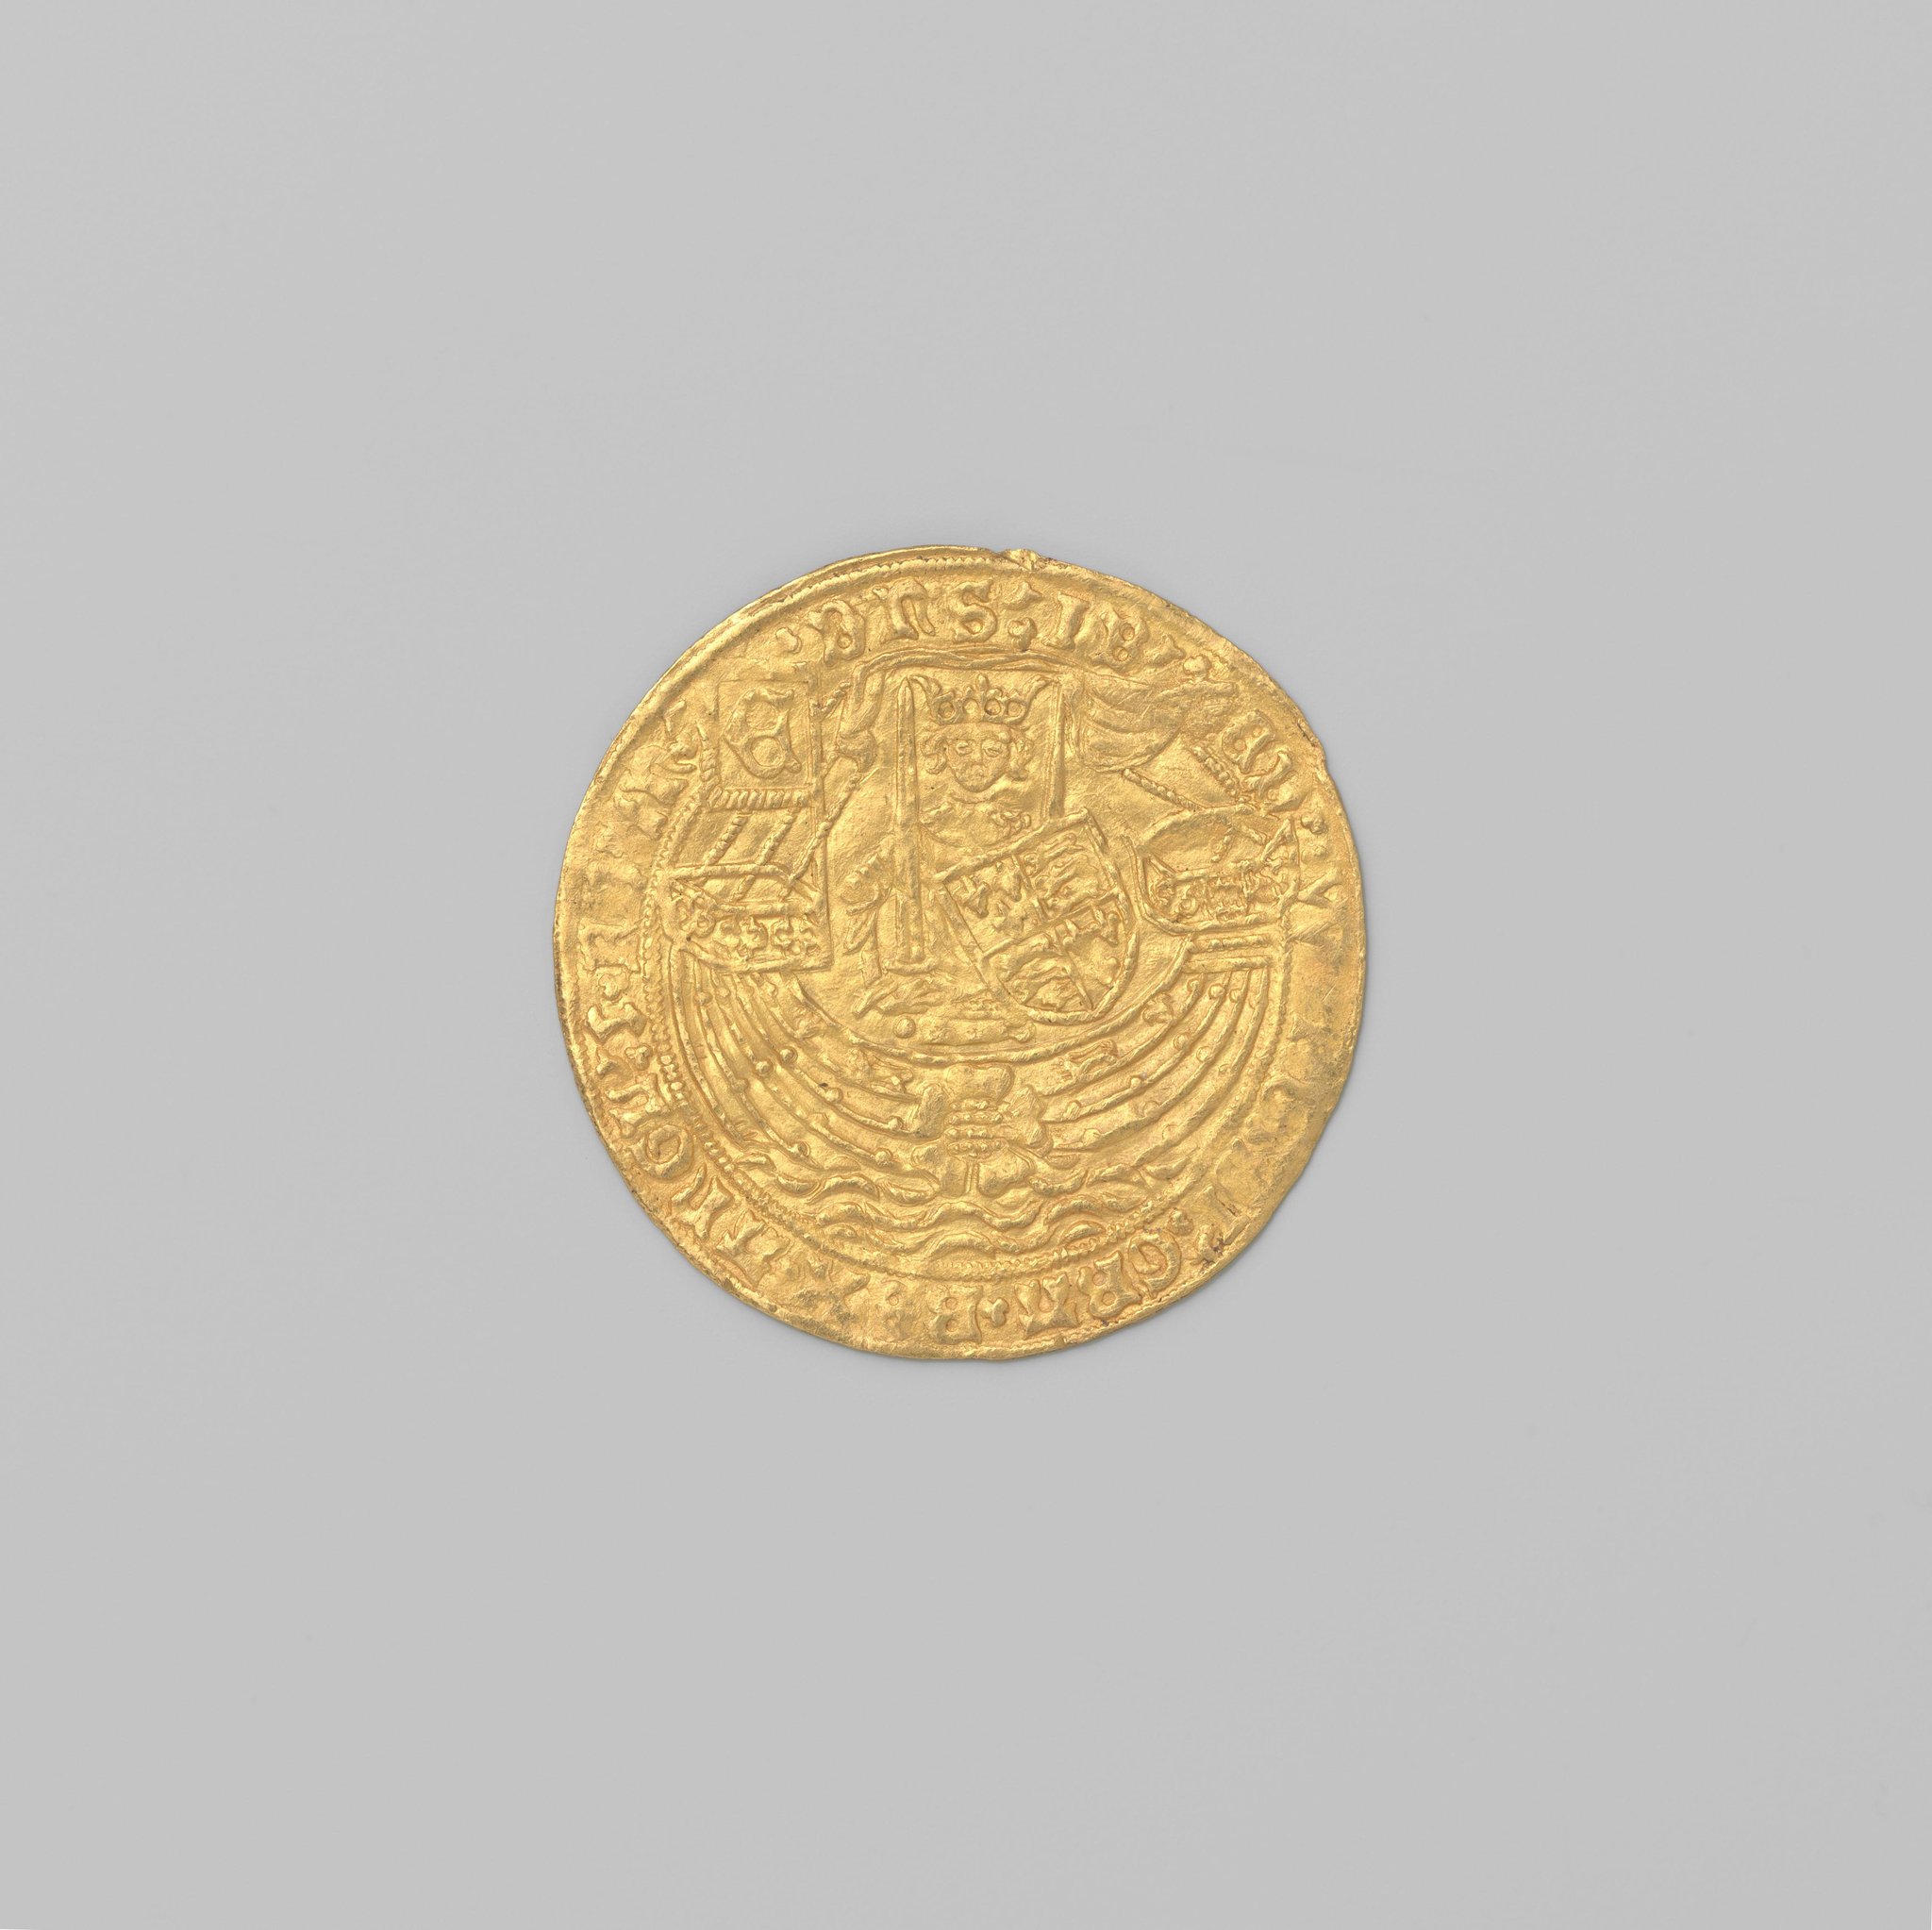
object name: rozenobel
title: Gouden rozenobel Gorkum / Gorinchem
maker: Anonymous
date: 1585-1587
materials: gold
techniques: striking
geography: gorinchem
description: Gouden handelsmunt afkomstig uit Nederlandse schatvondst (Urk 1995).